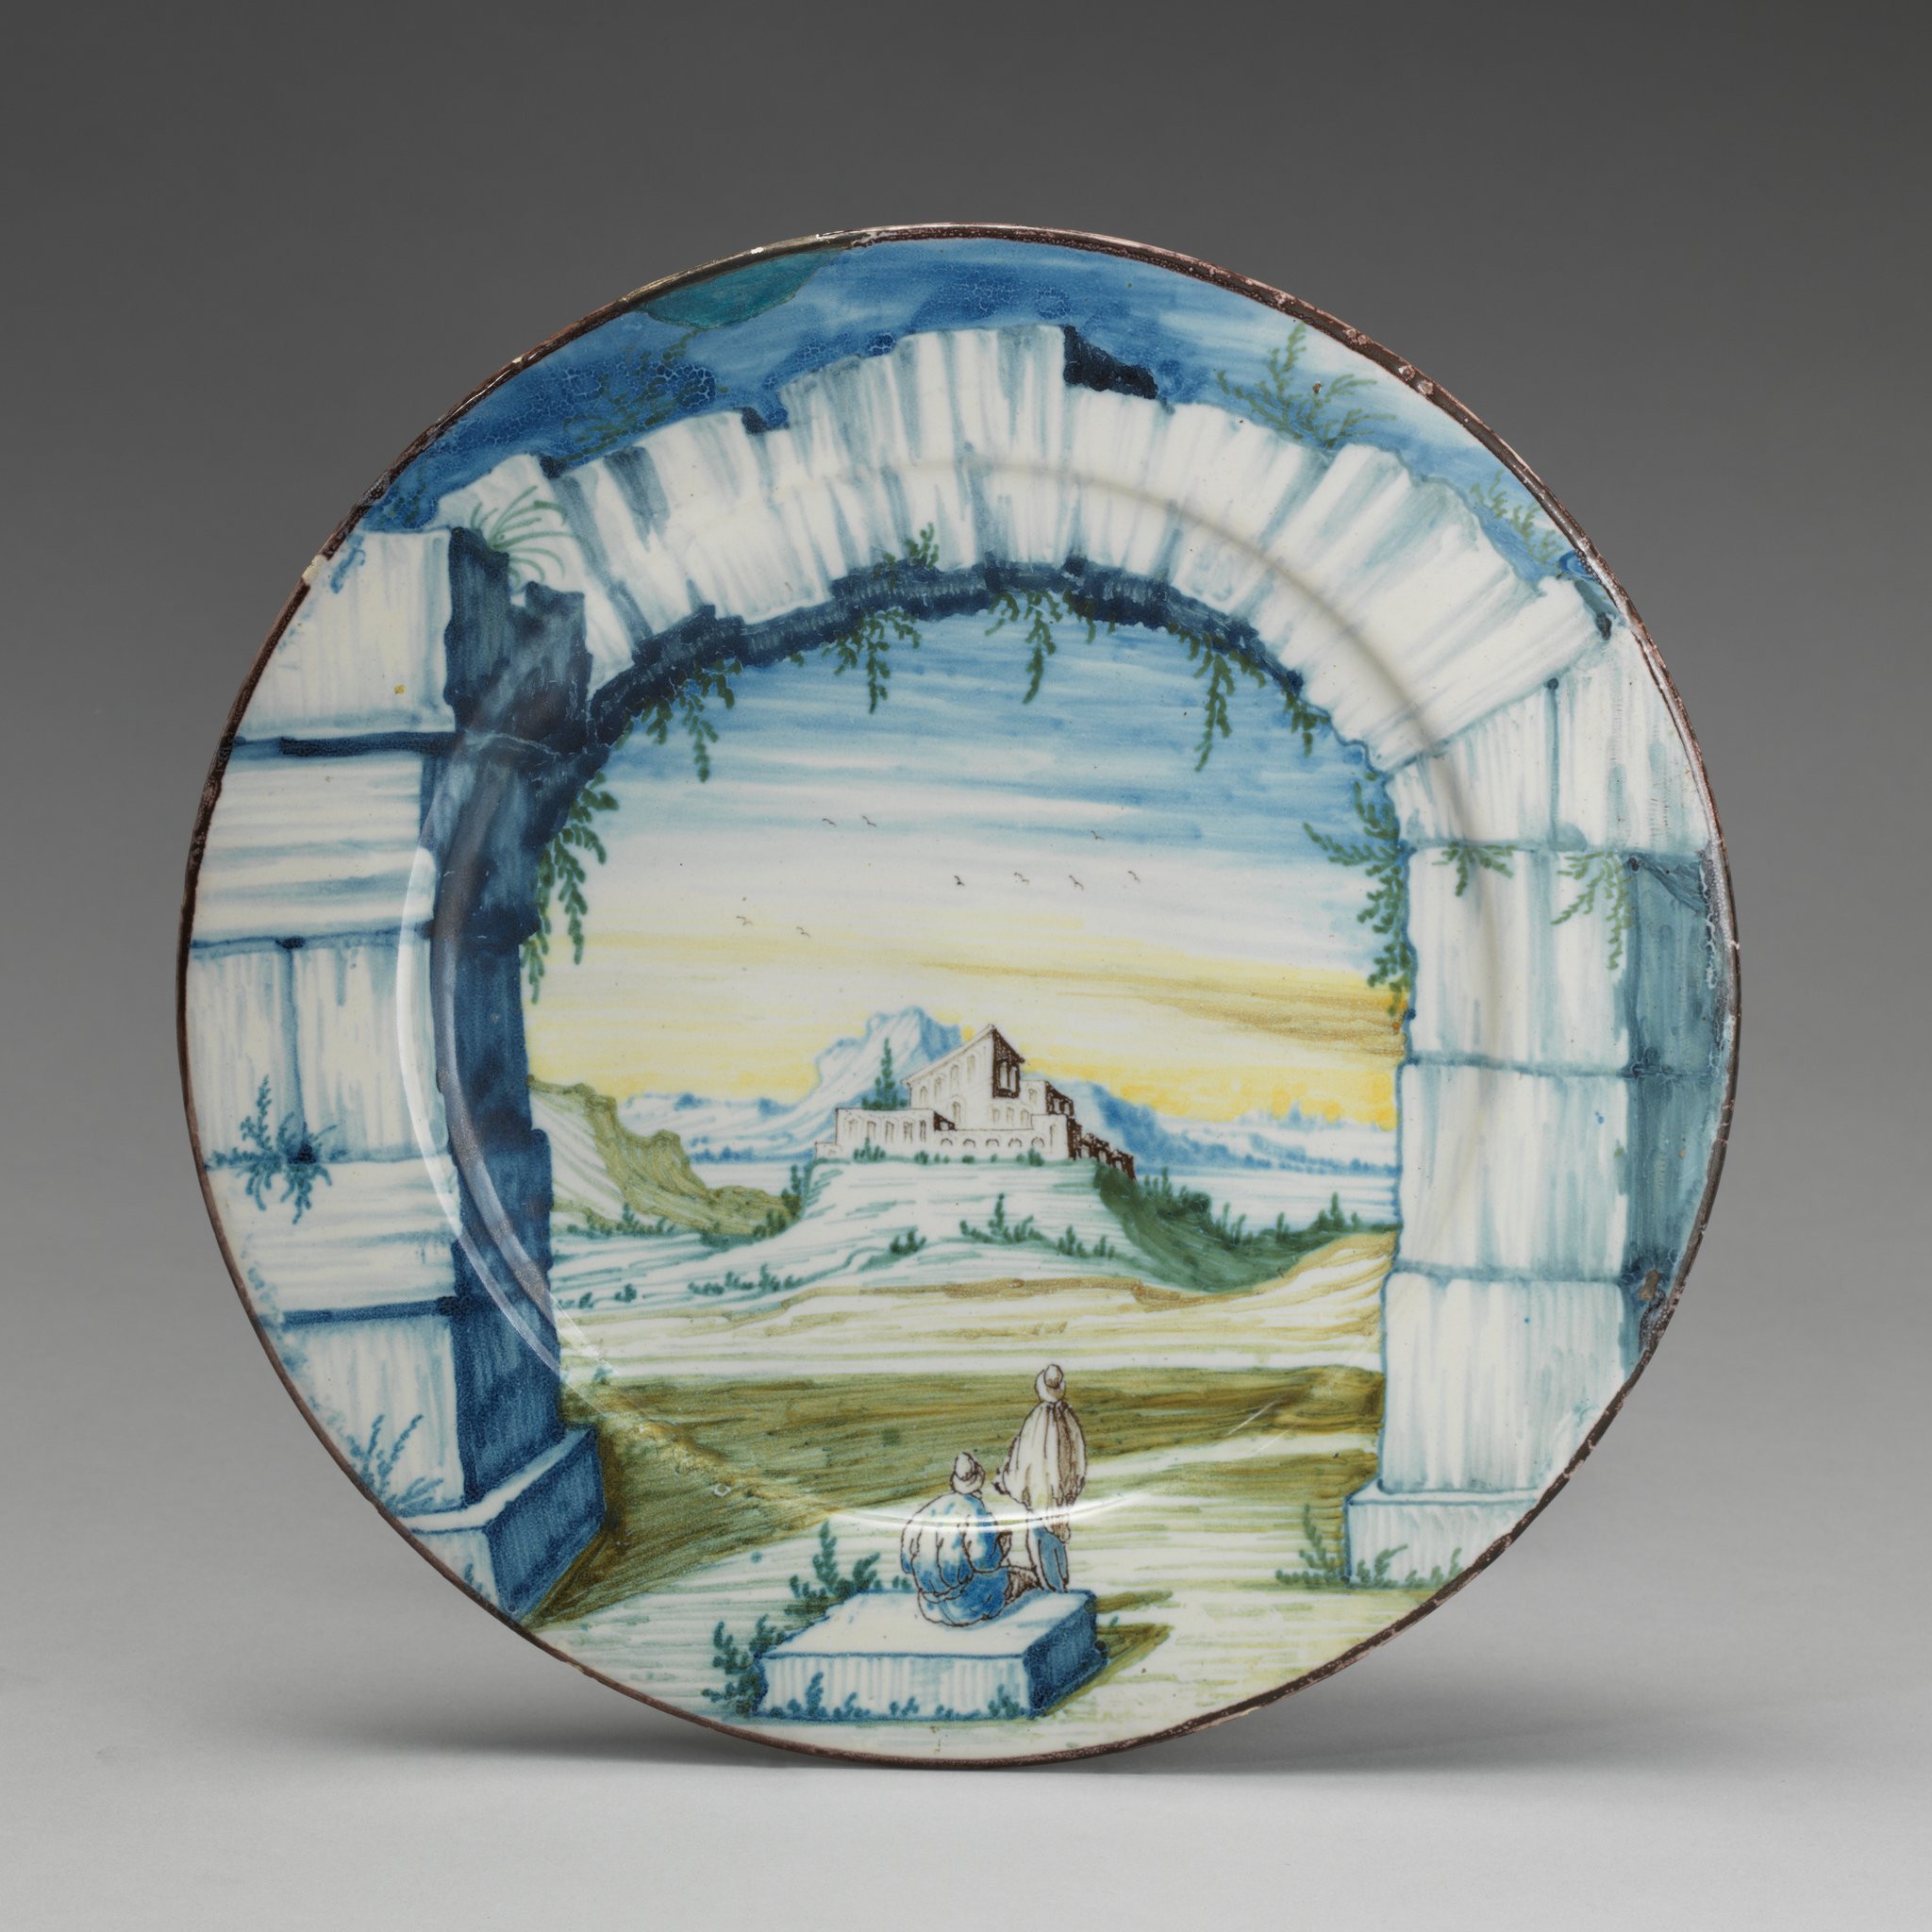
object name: dish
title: Dish with landscape seen though an arch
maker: siro antonio africa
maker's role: artist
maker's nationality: italian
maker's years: 1663-1735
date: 1700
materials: earthenware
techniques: maiolica, glazing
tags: arches,landscapes